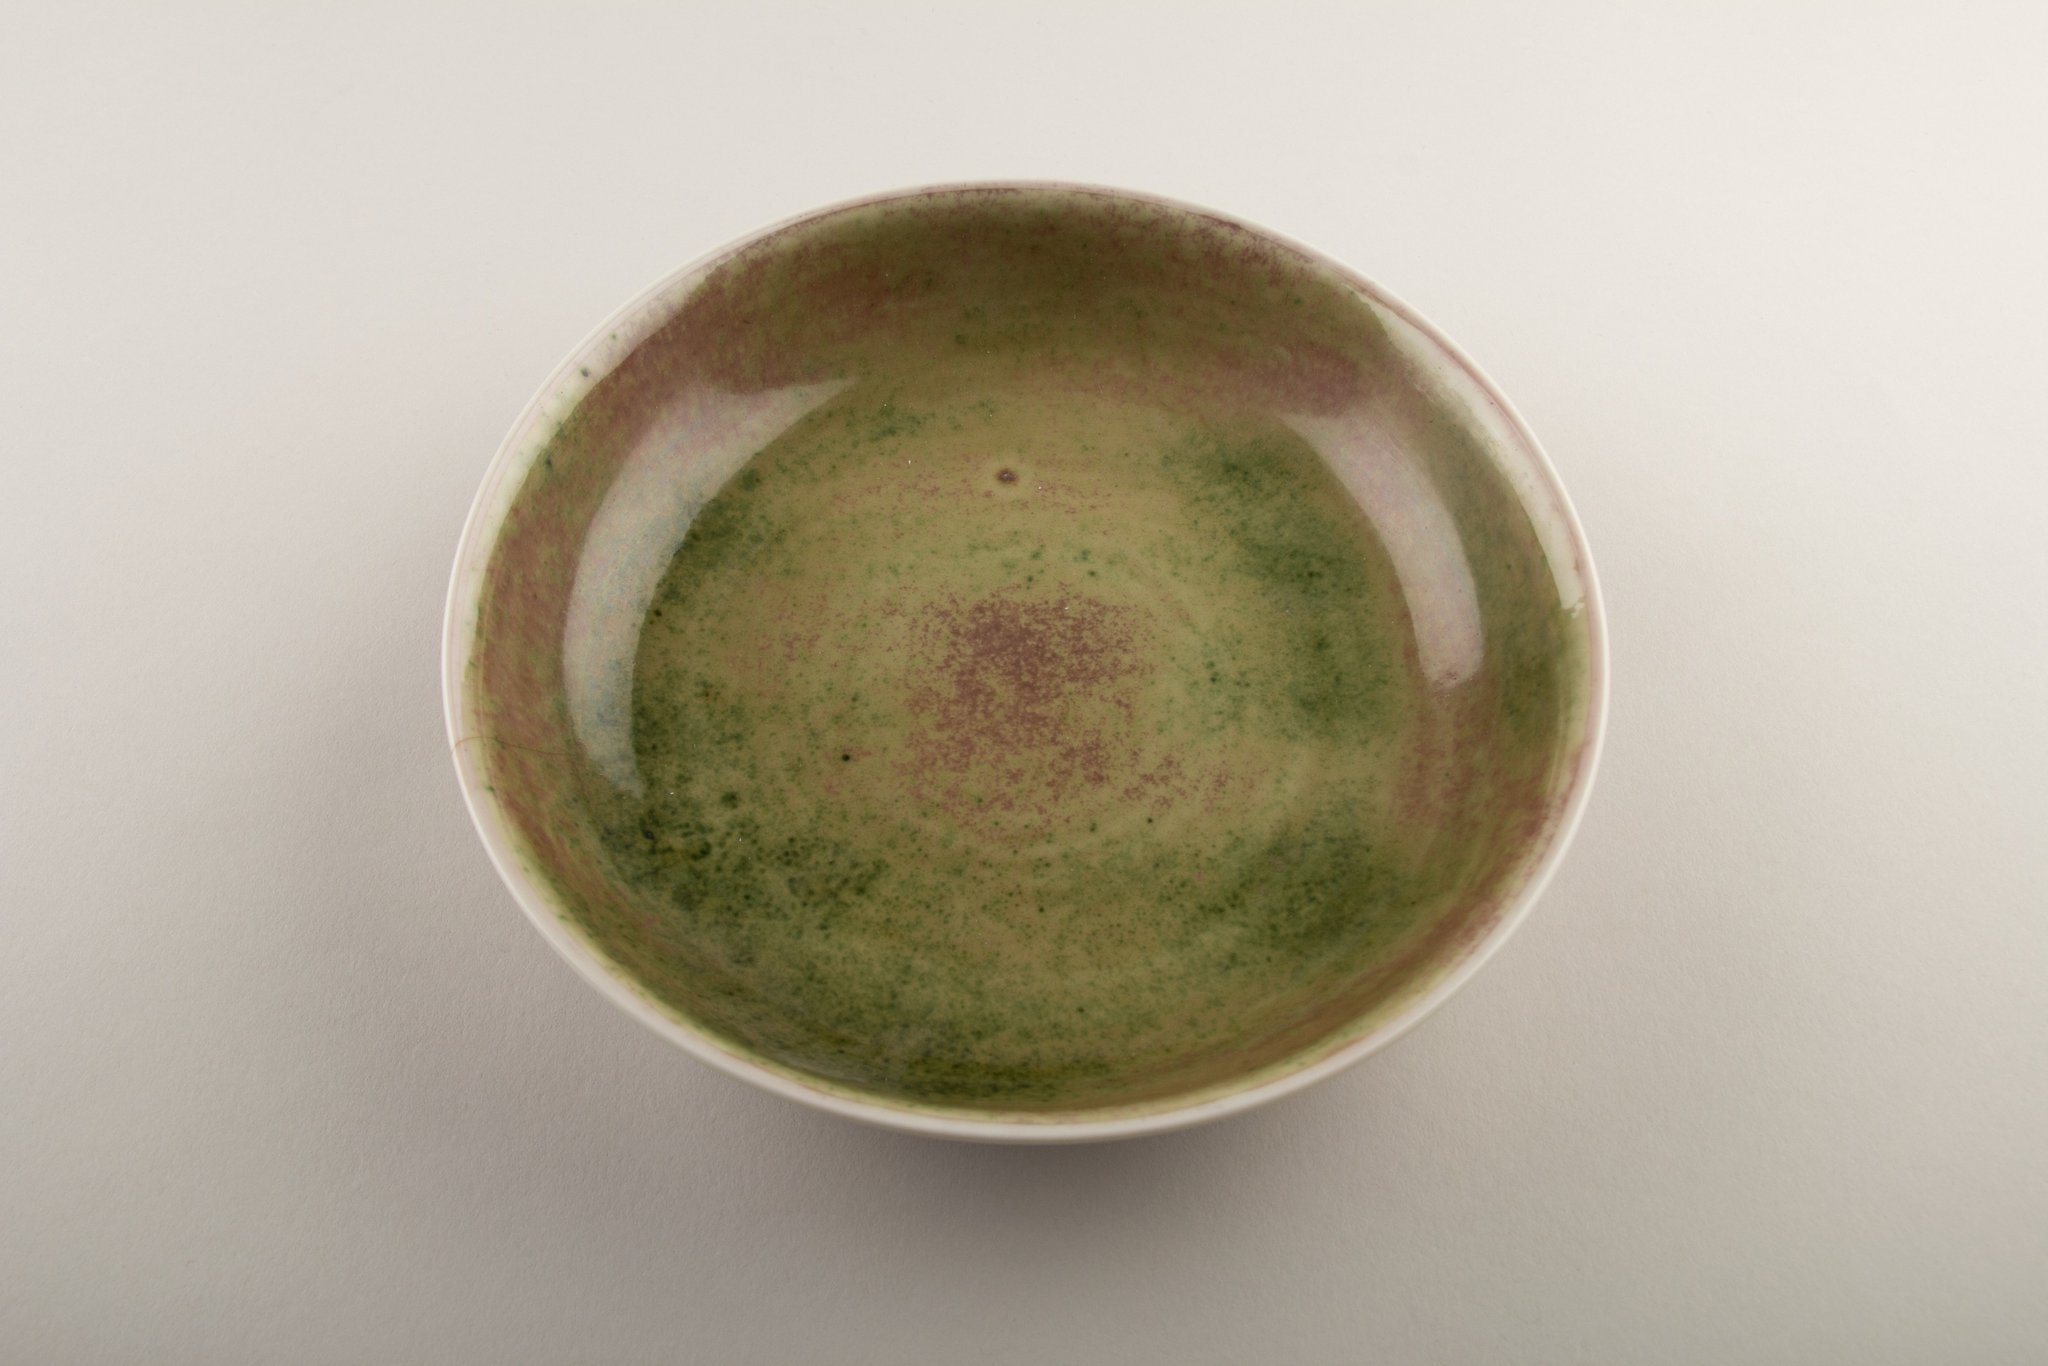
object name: plate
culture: chinese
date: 1662-1722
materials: porcelain